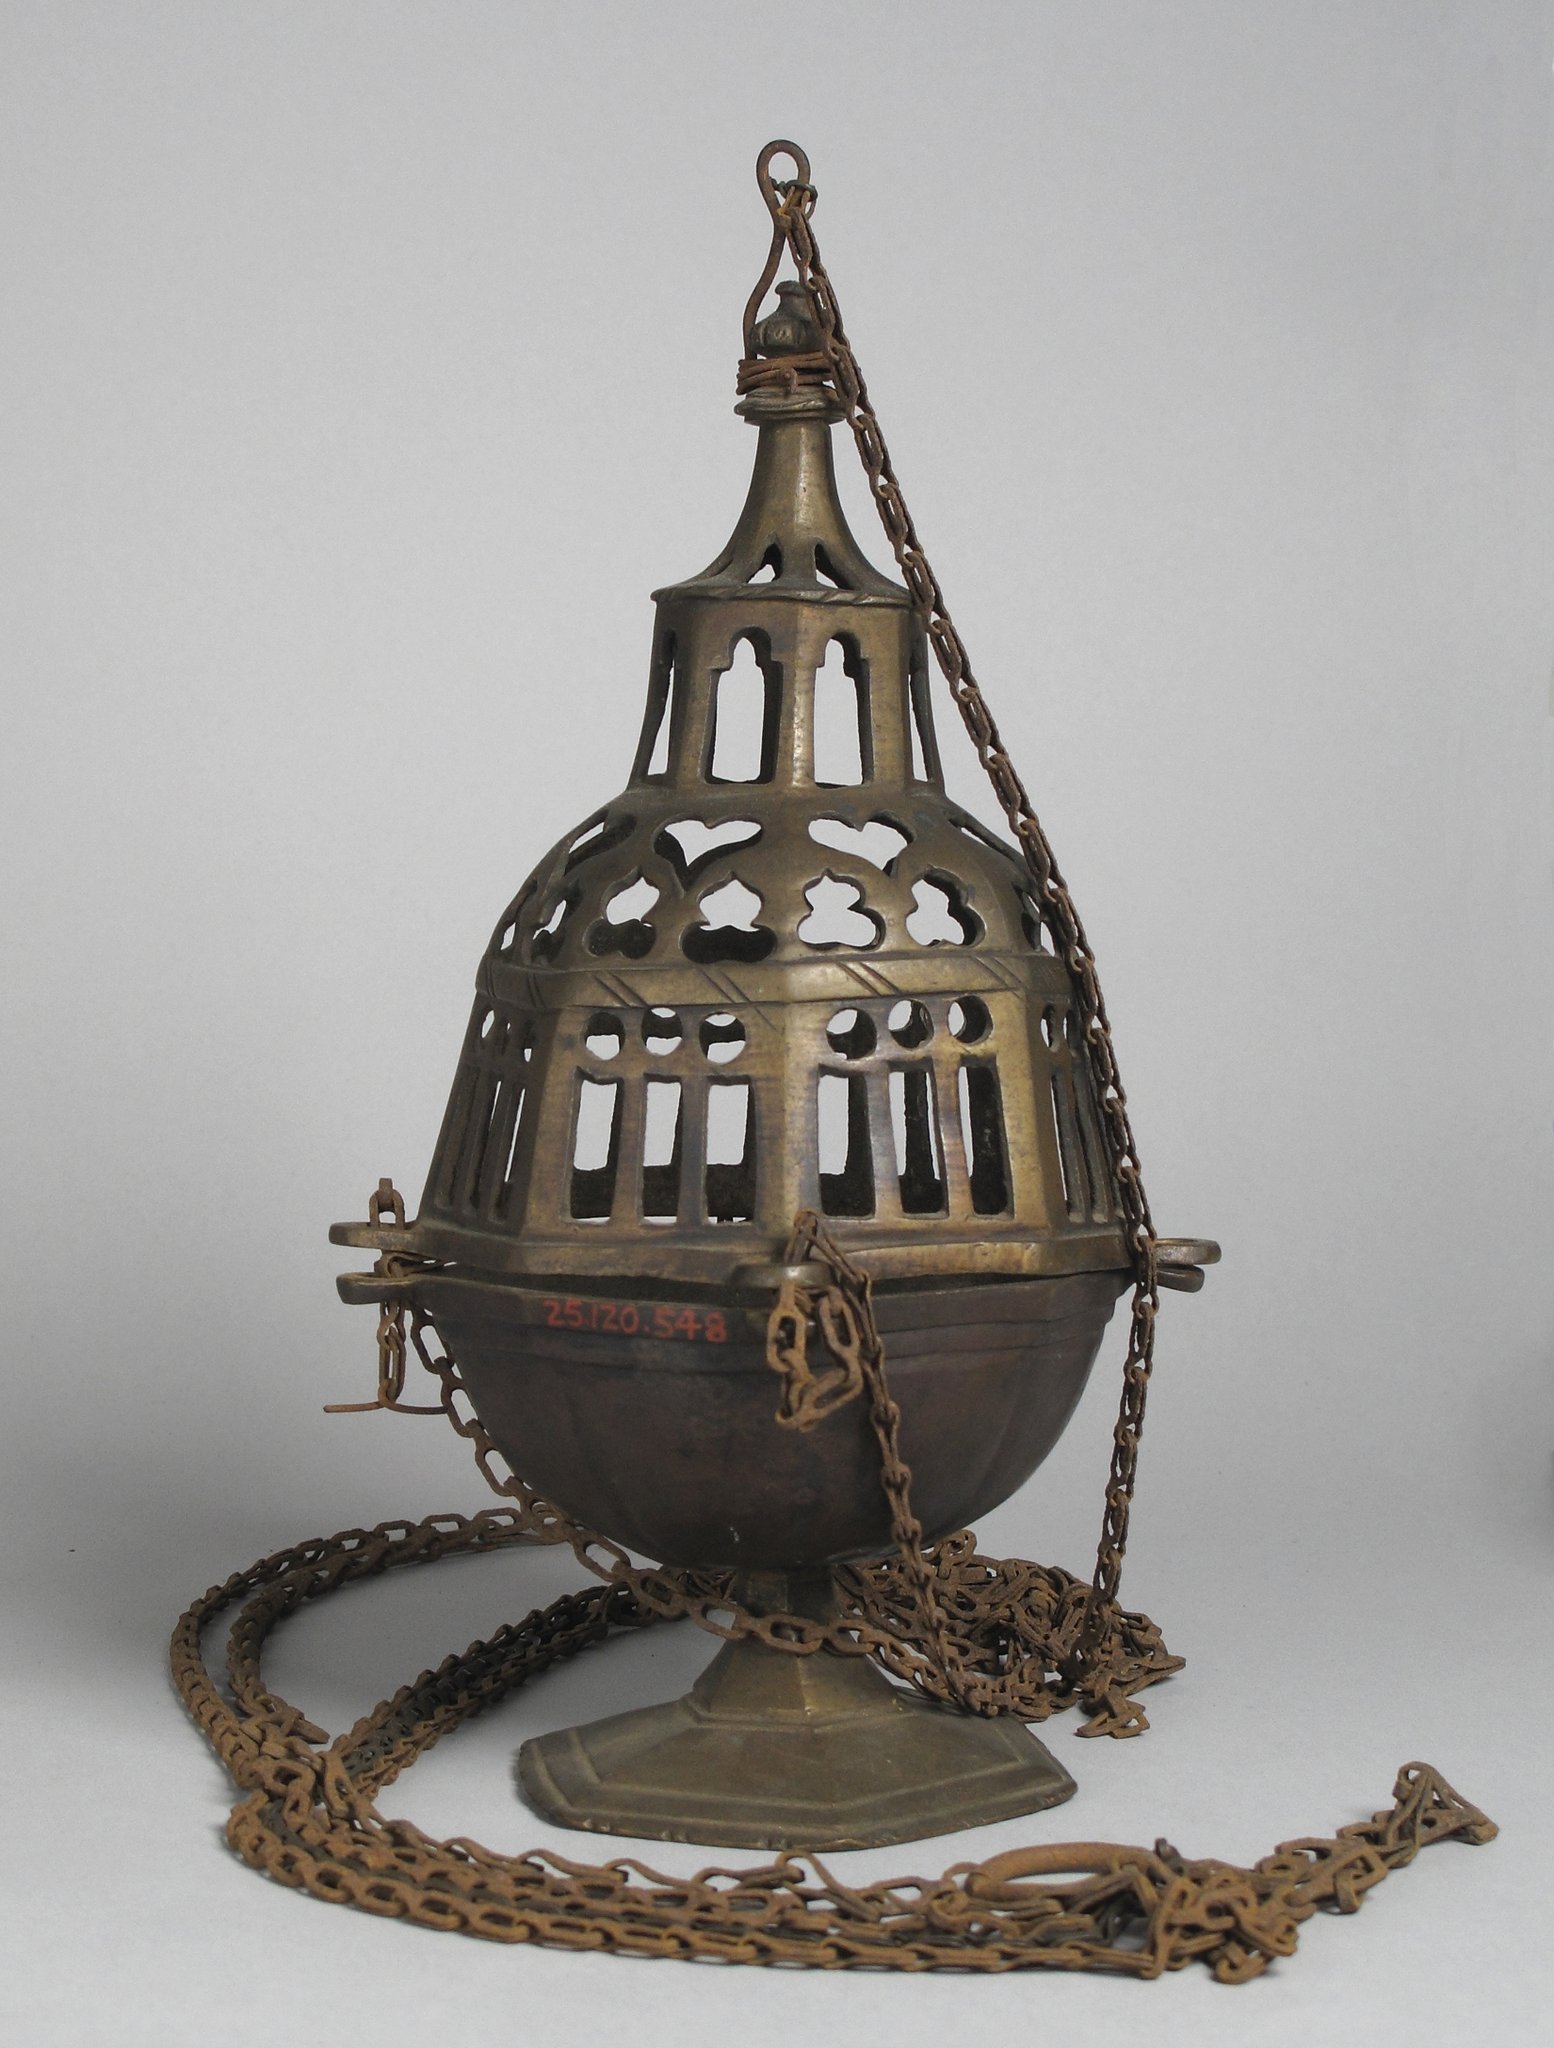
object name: censer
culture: french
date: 1501-1600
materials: brass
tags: censers